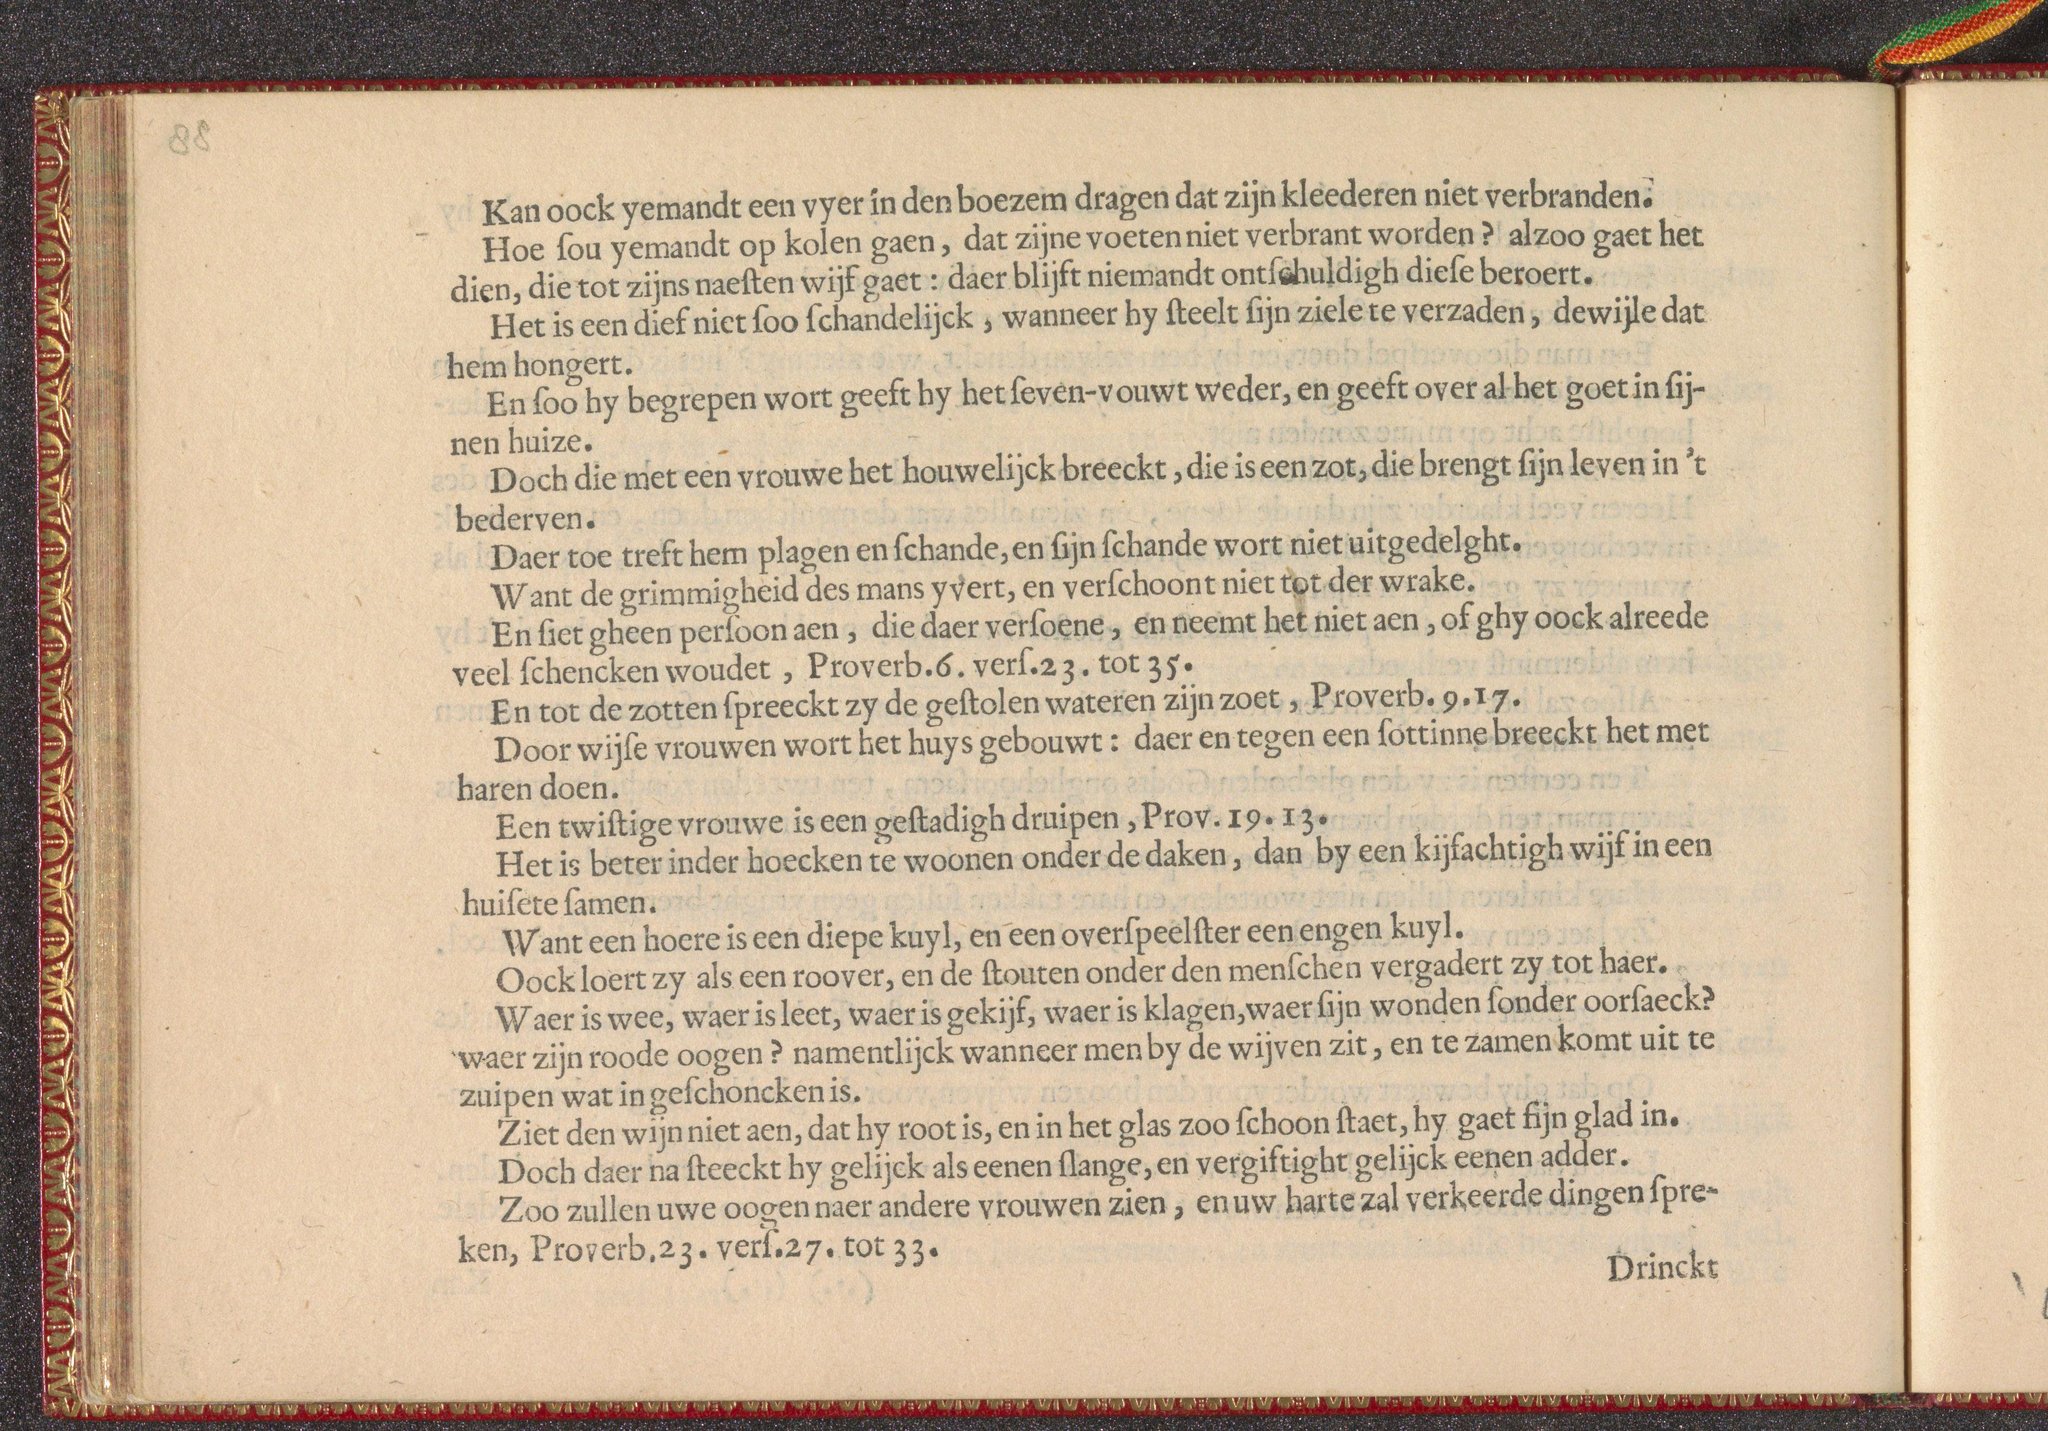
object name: text sheet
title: Les abus du mariage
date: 1641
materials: paper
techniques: letterpress printing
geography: amsterdam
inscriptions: date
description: Waarschuwing op vijf pagina's: pagina 4. Het blad maakt deel uit van een album.